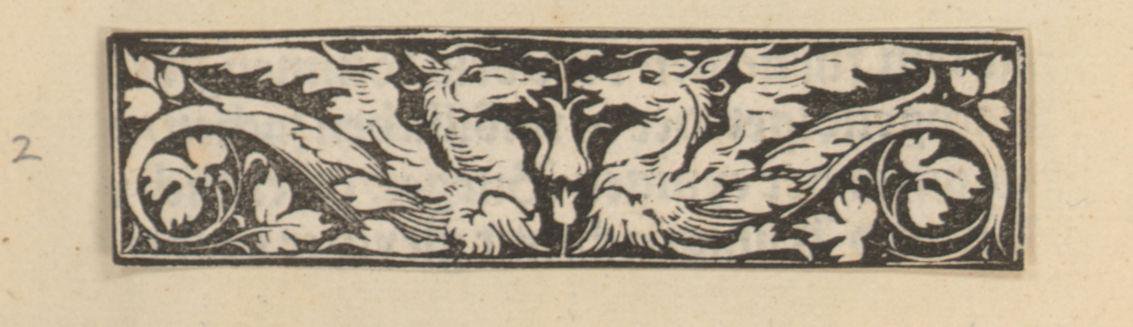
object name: book illustration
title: Twee gevleugelde fabeldieren met paardenhoofden en ornamenten met bladmotief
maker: Anonymous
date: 1514-1532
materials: paper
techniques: letterpress printing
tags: foliage ~ ornament, fabulous animals ~ hoofed animals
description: Deze prent is gebruikt als ornament in: Petrarca, Francesco. Von der Artzney bayder Glück, des guten und widerwertigen: unnd weß sich ain yeder inn Gelück und Unglück halten sol (...). Augsburg: Heinrich Steiner, 1532. Deze uitgave is ook bekend onder de titel 'Trostspiegel in Glück und Unglück'.